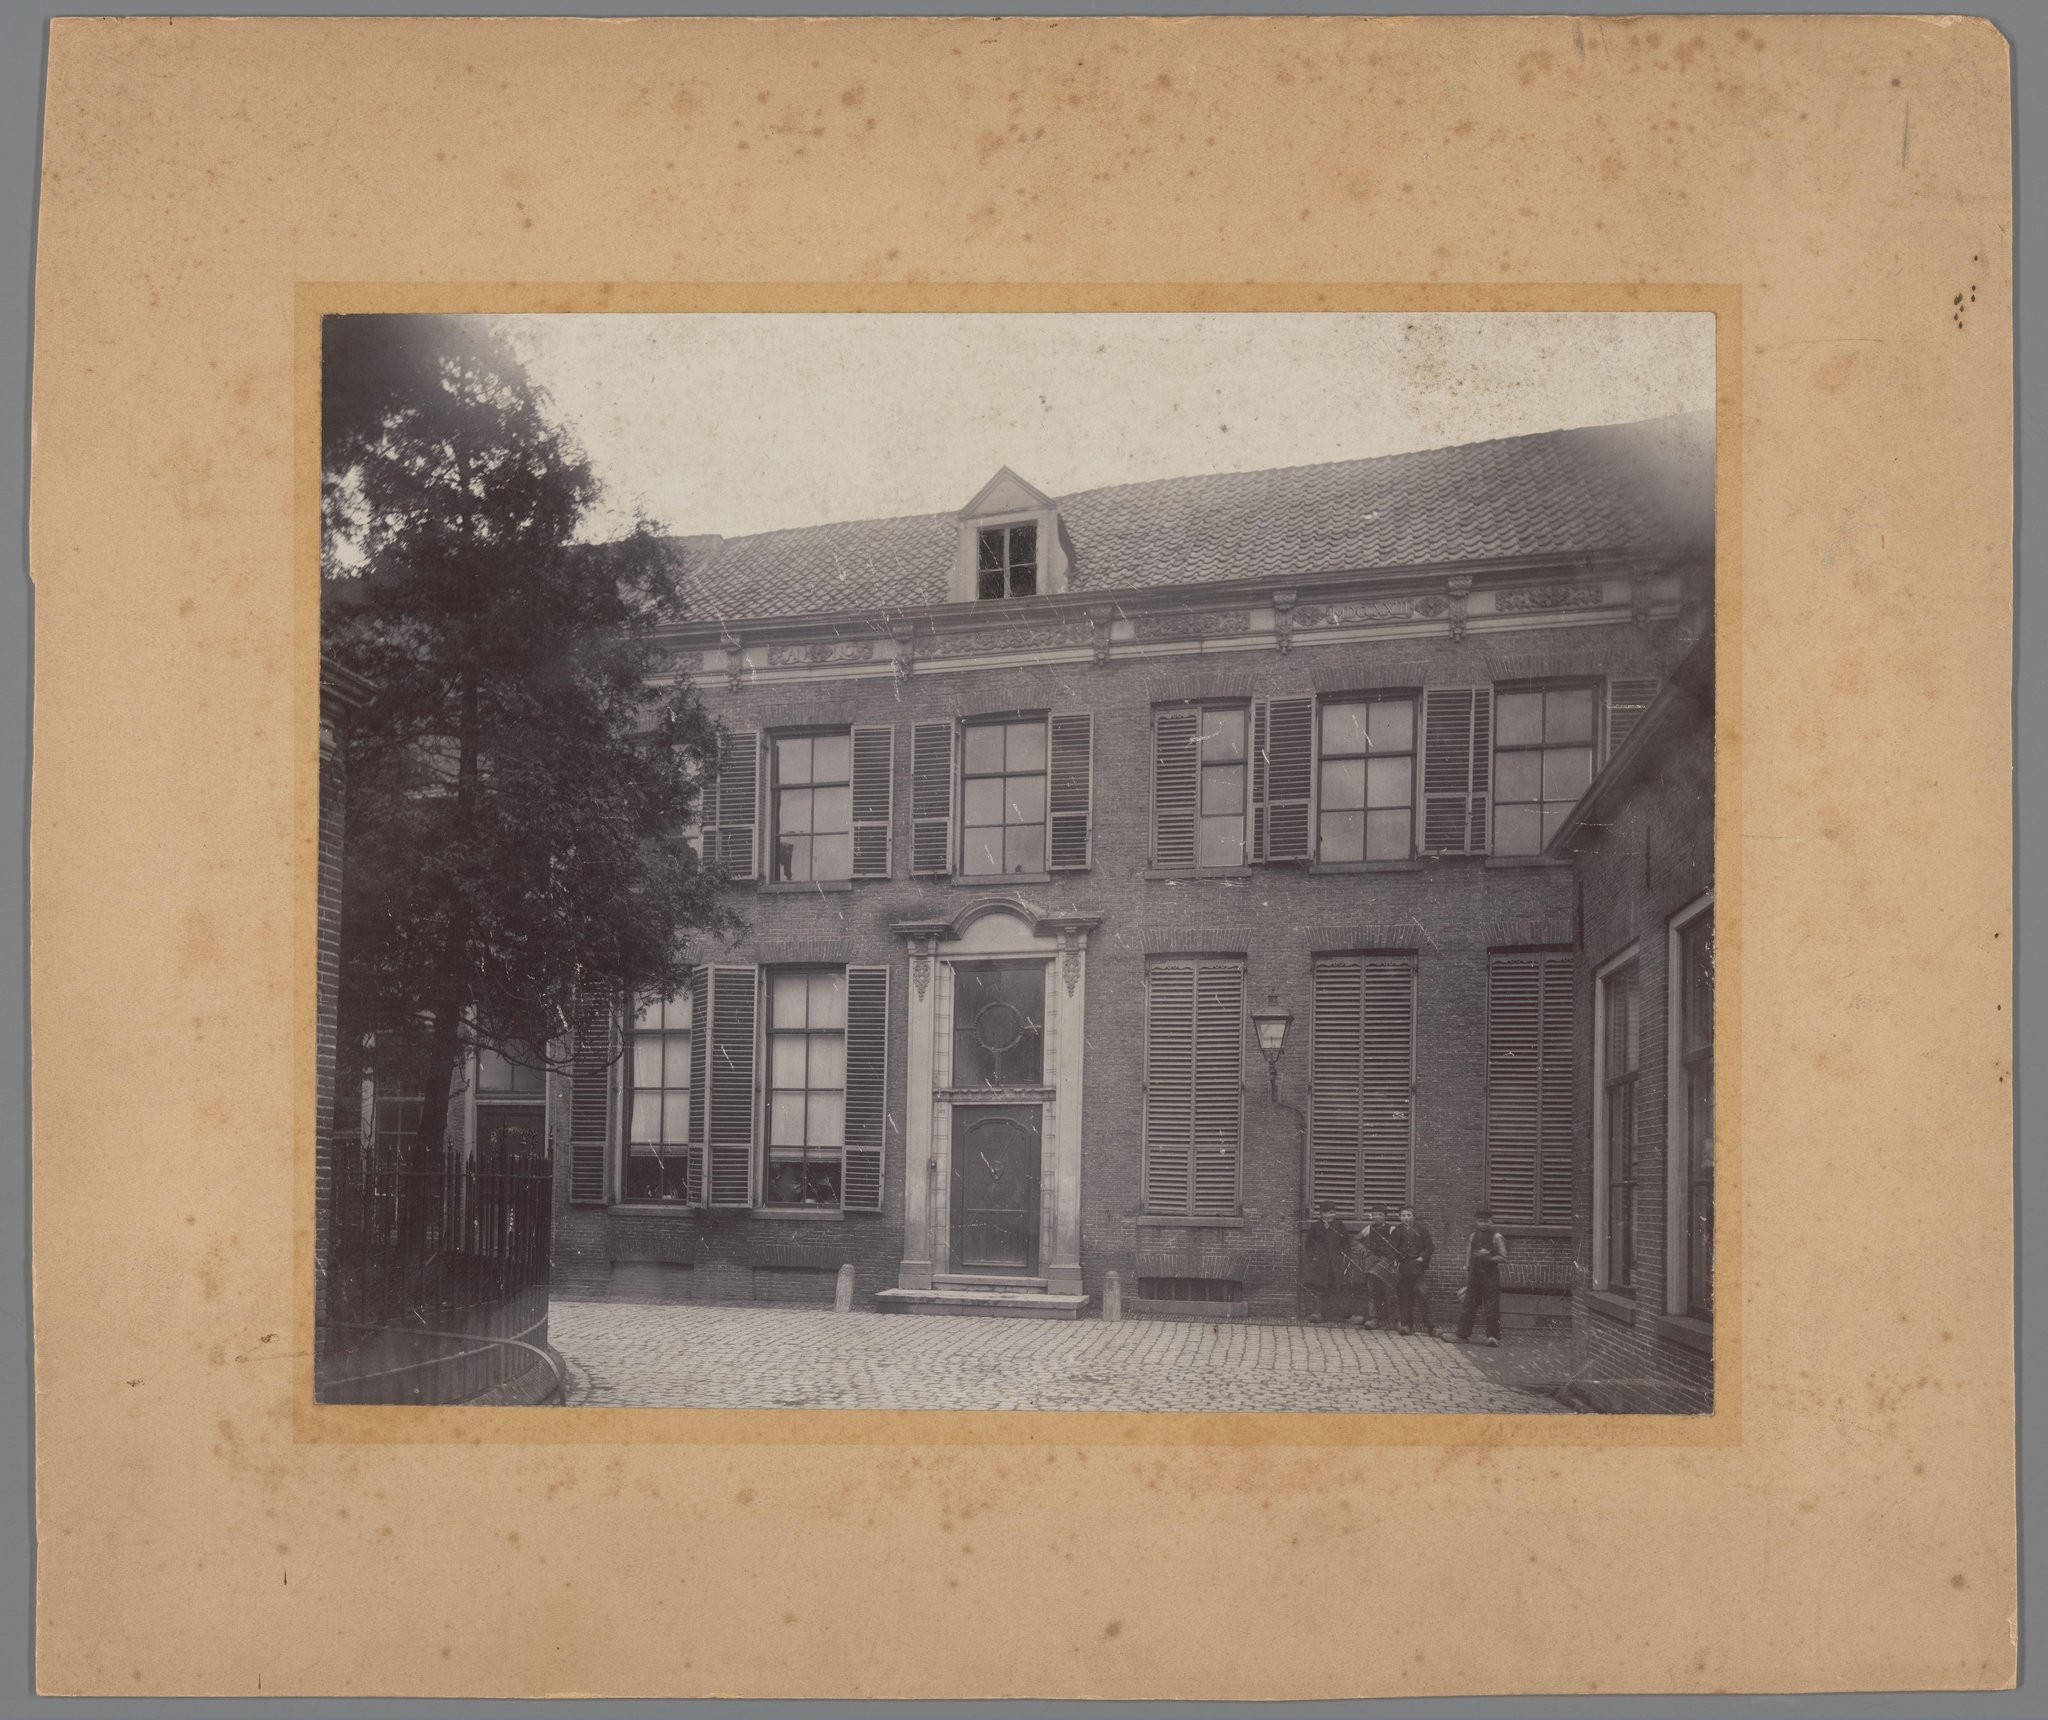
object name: photograph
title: Gebouw in de Schoutensteeg te Zwolle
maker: johannes jacobus dirk de graaf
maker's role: fotograaf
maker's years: 1866-1927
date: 1898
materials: cardboard, photographic support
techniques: collodion silver print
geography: zwolle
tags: façade (of house or building)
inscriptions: inscription: ‘Johs. de Graaf/ Photografie/ Zwolle’, annotation: ‘Gephotografeerd Maart 1898, kort voor de afbraak/ Zwolle Schoutensteeg (...) In den zomer van 1898 is op de plaats van het afgebroken gebouw de [Synage] gezet/ Fotografie/ Zwolle/ R.M.’, inscription: ‘J.J.D. De Graaf Zwolle’